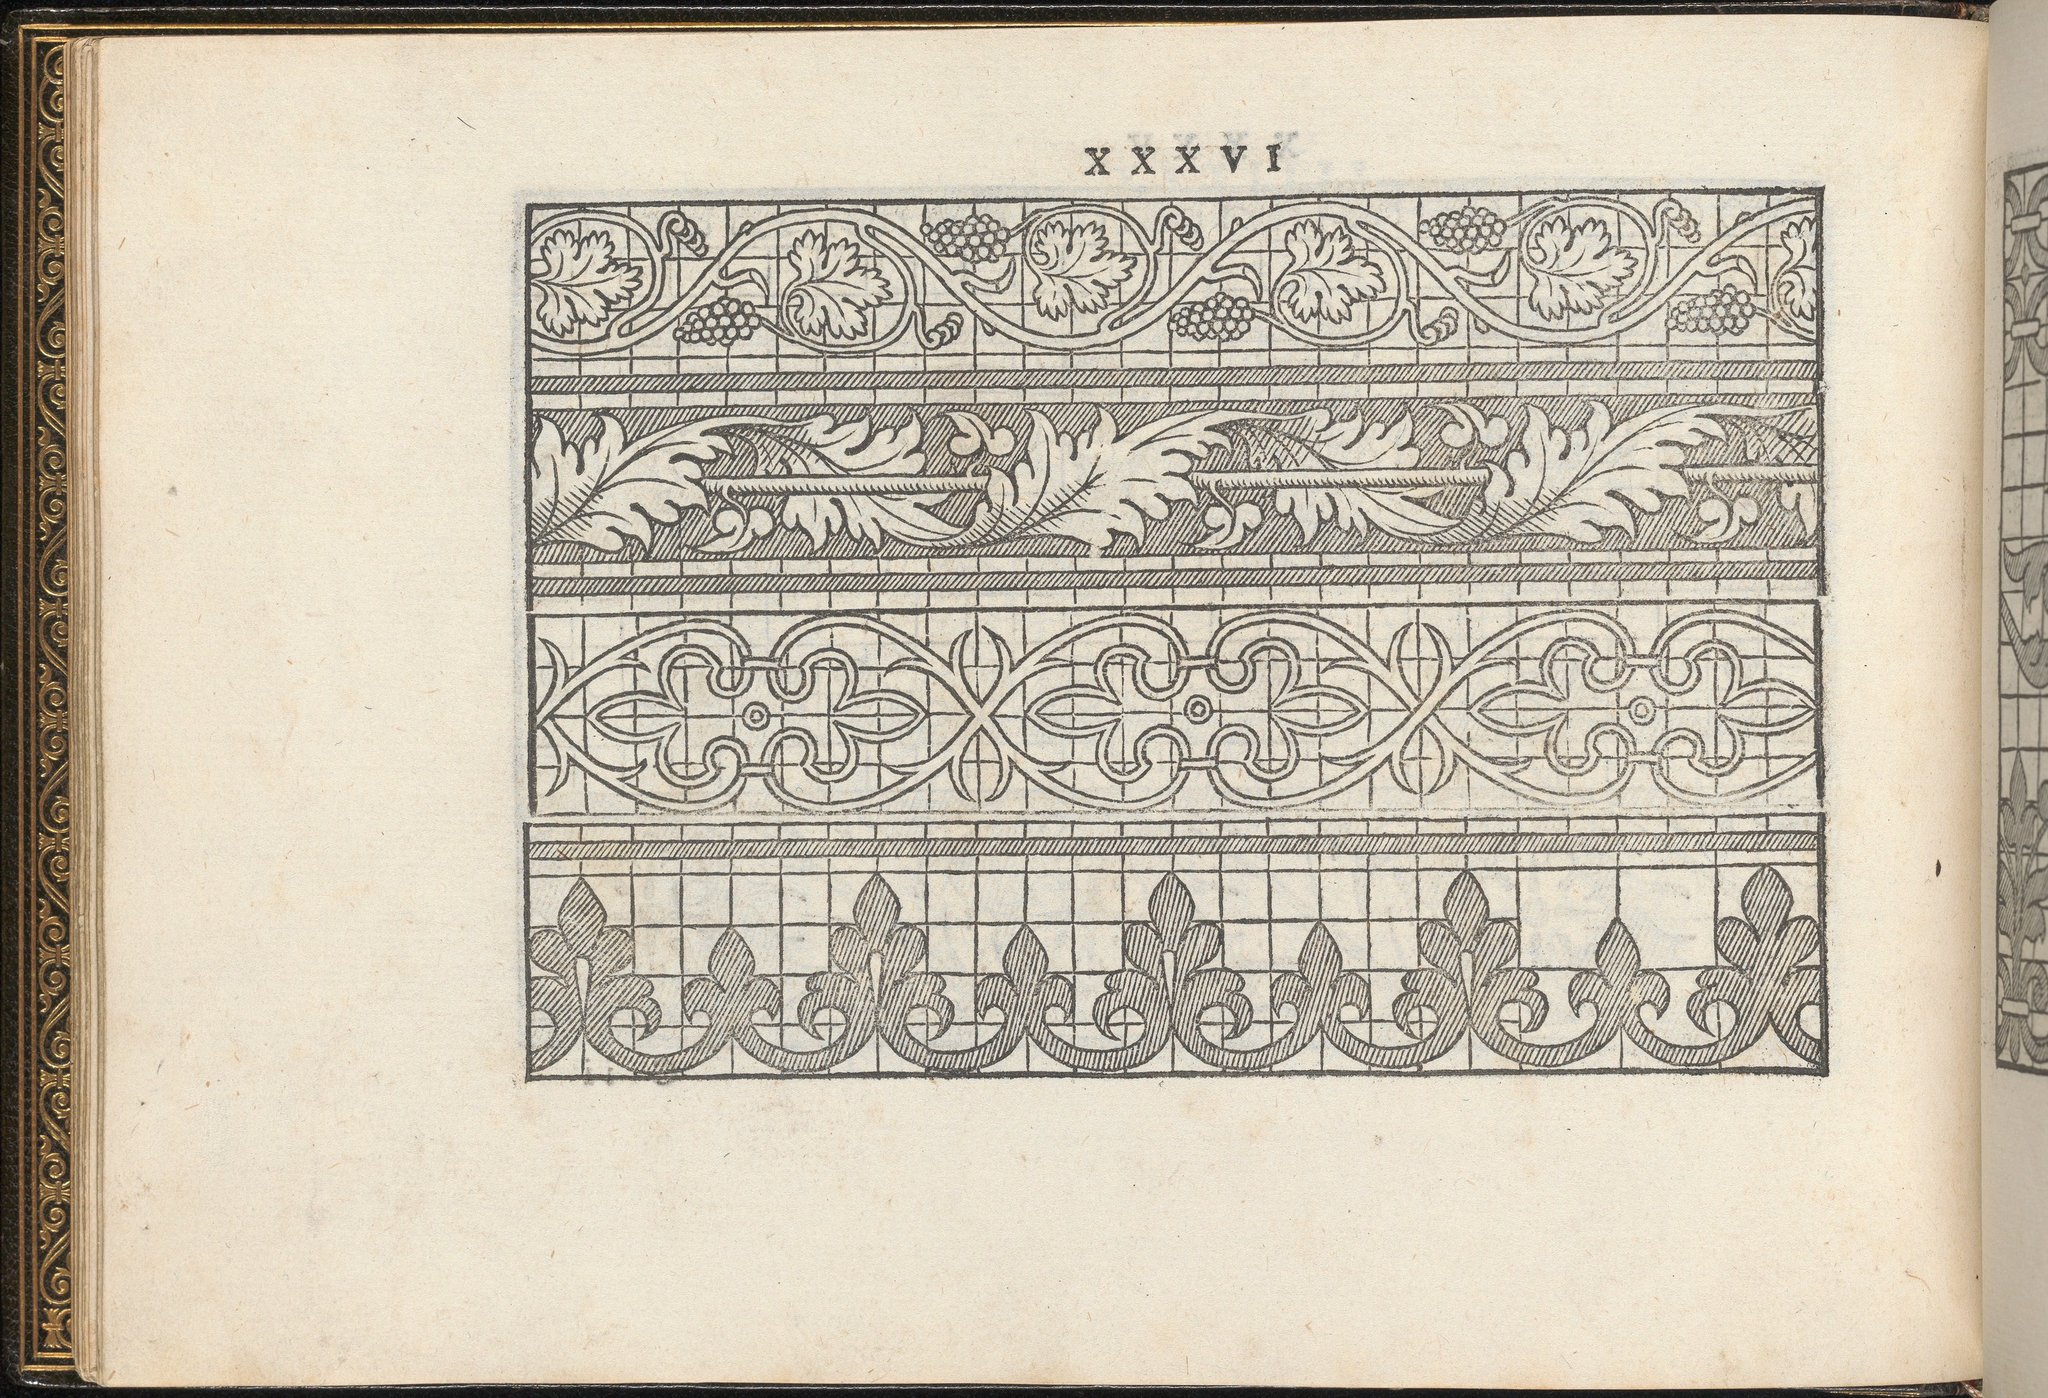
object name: book print ornament architecture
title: La Vera Perfettione del Disegno di varie sorti di recami, page 18 (verso)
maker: giovanni ostaus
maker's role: publisher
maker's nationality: italian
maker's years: 1507-1607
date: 1567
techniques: woodcut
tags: vines